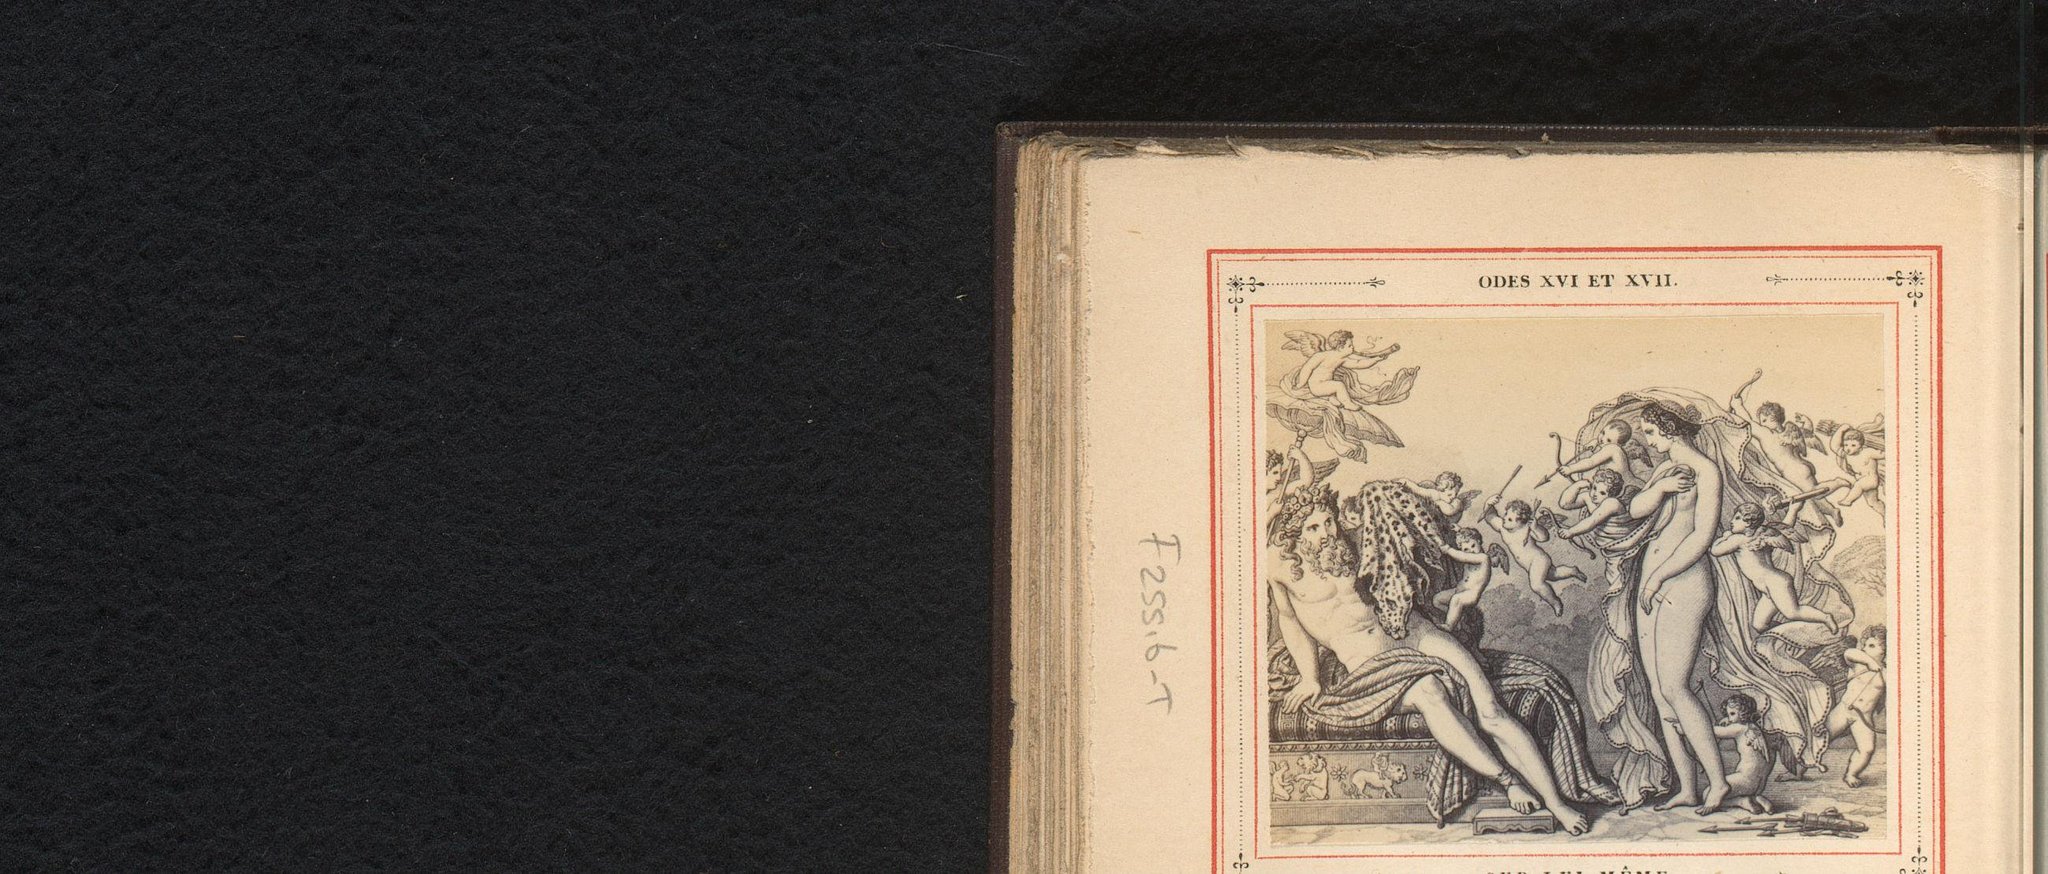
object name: reproduction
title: Sur lui-même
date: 1859-1864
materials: paper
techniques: albumen print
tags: gods ~ classical mythology